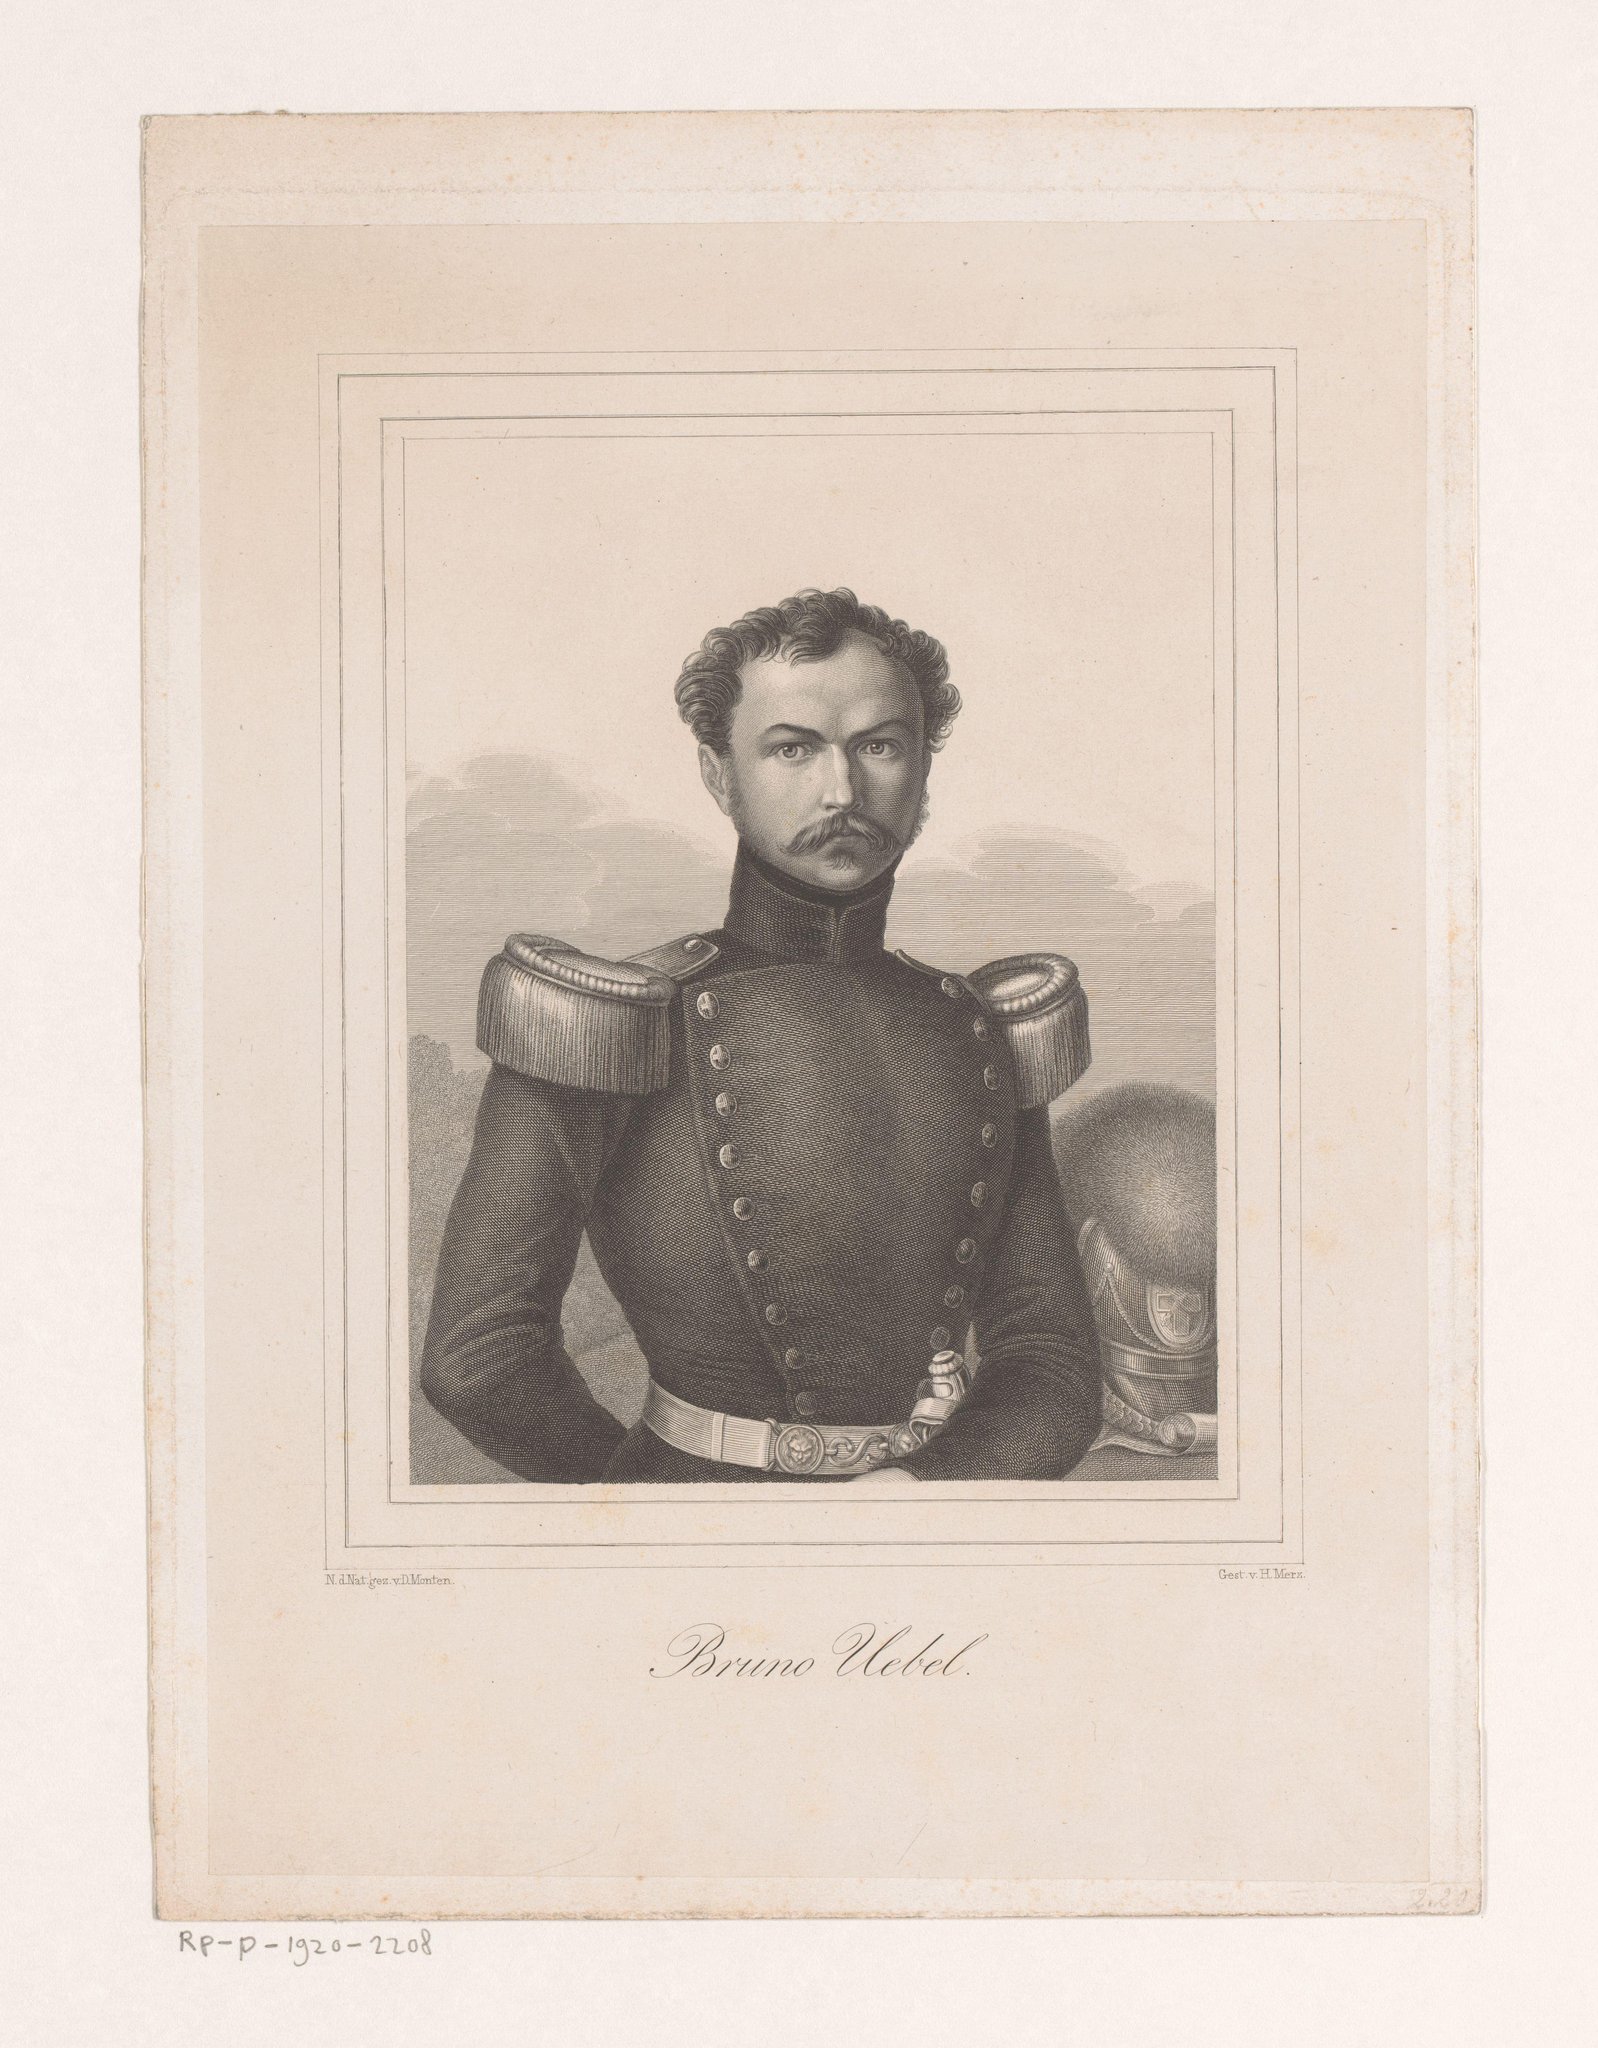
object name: print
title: Portret van Bruno Uebel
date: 1816-1875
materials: paper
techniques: engraving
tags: helmet, historical persons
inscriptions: collector's mark: Lugt 2228